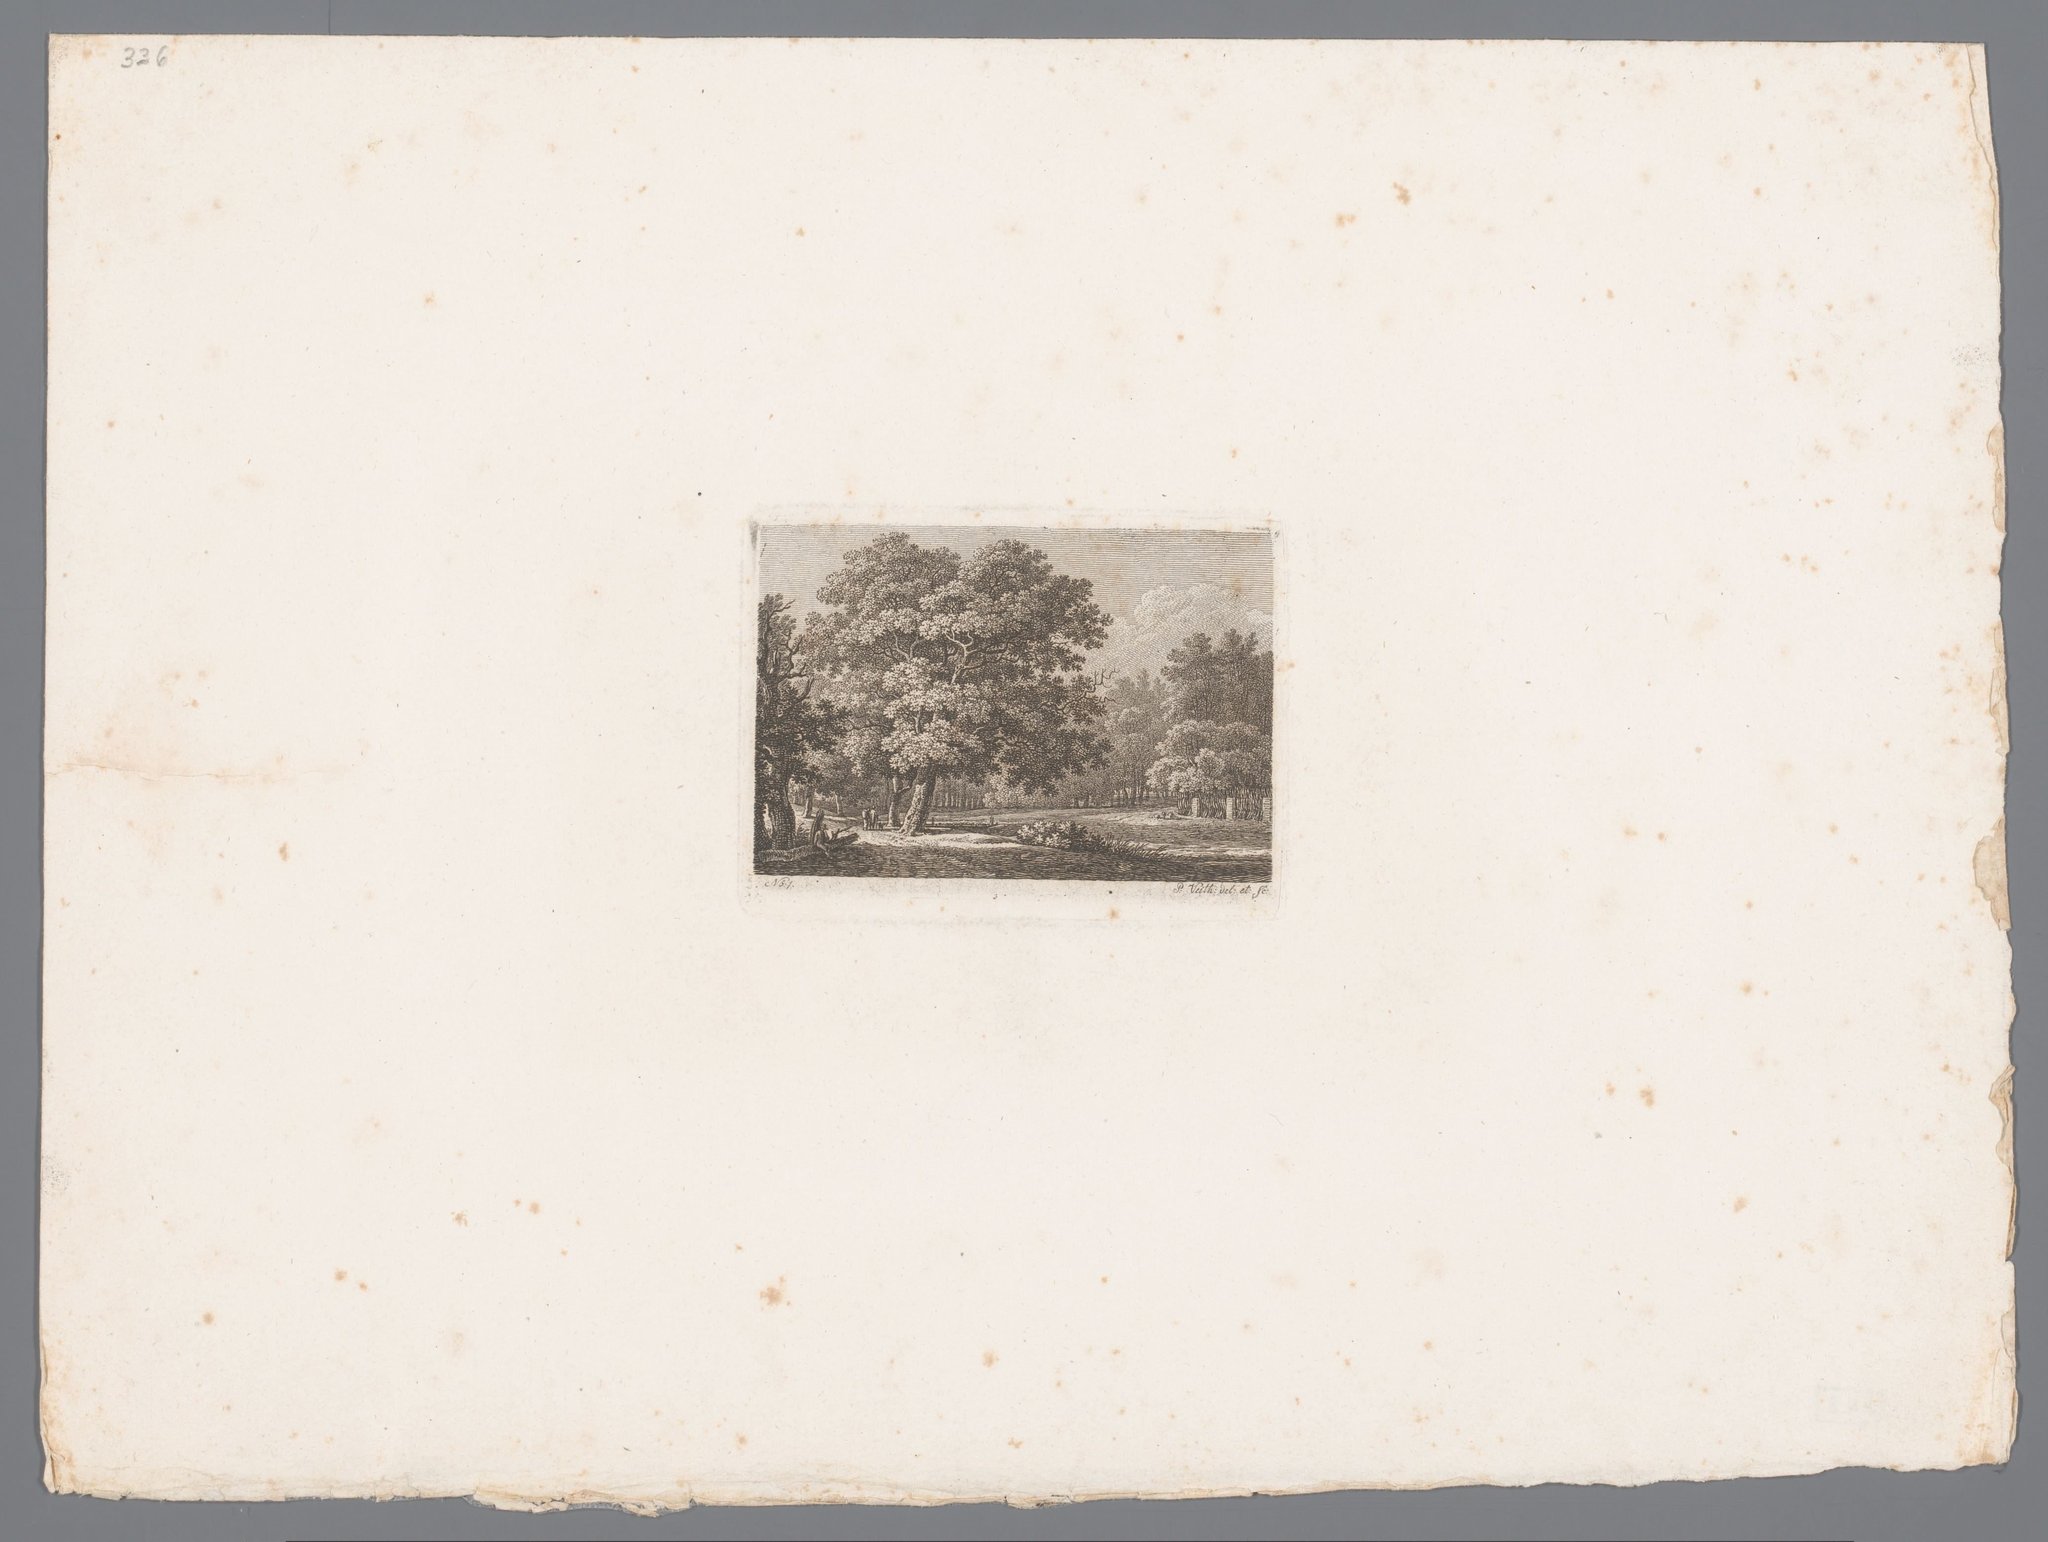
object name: print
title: Bezigheden in de vrije tijd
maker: philipp veith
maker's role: draughtsman, print maker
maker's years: 1768-1837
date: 1824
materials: paper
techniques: etching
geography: dresden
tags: walking, hiking (recreation), landscapes, forest, wood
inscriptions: number: ‘336’, collector's mark: Lugt 3976, collector's mark: Lugt 2228, number: ‘223003/0295’, collector's mark: Lugt 2760